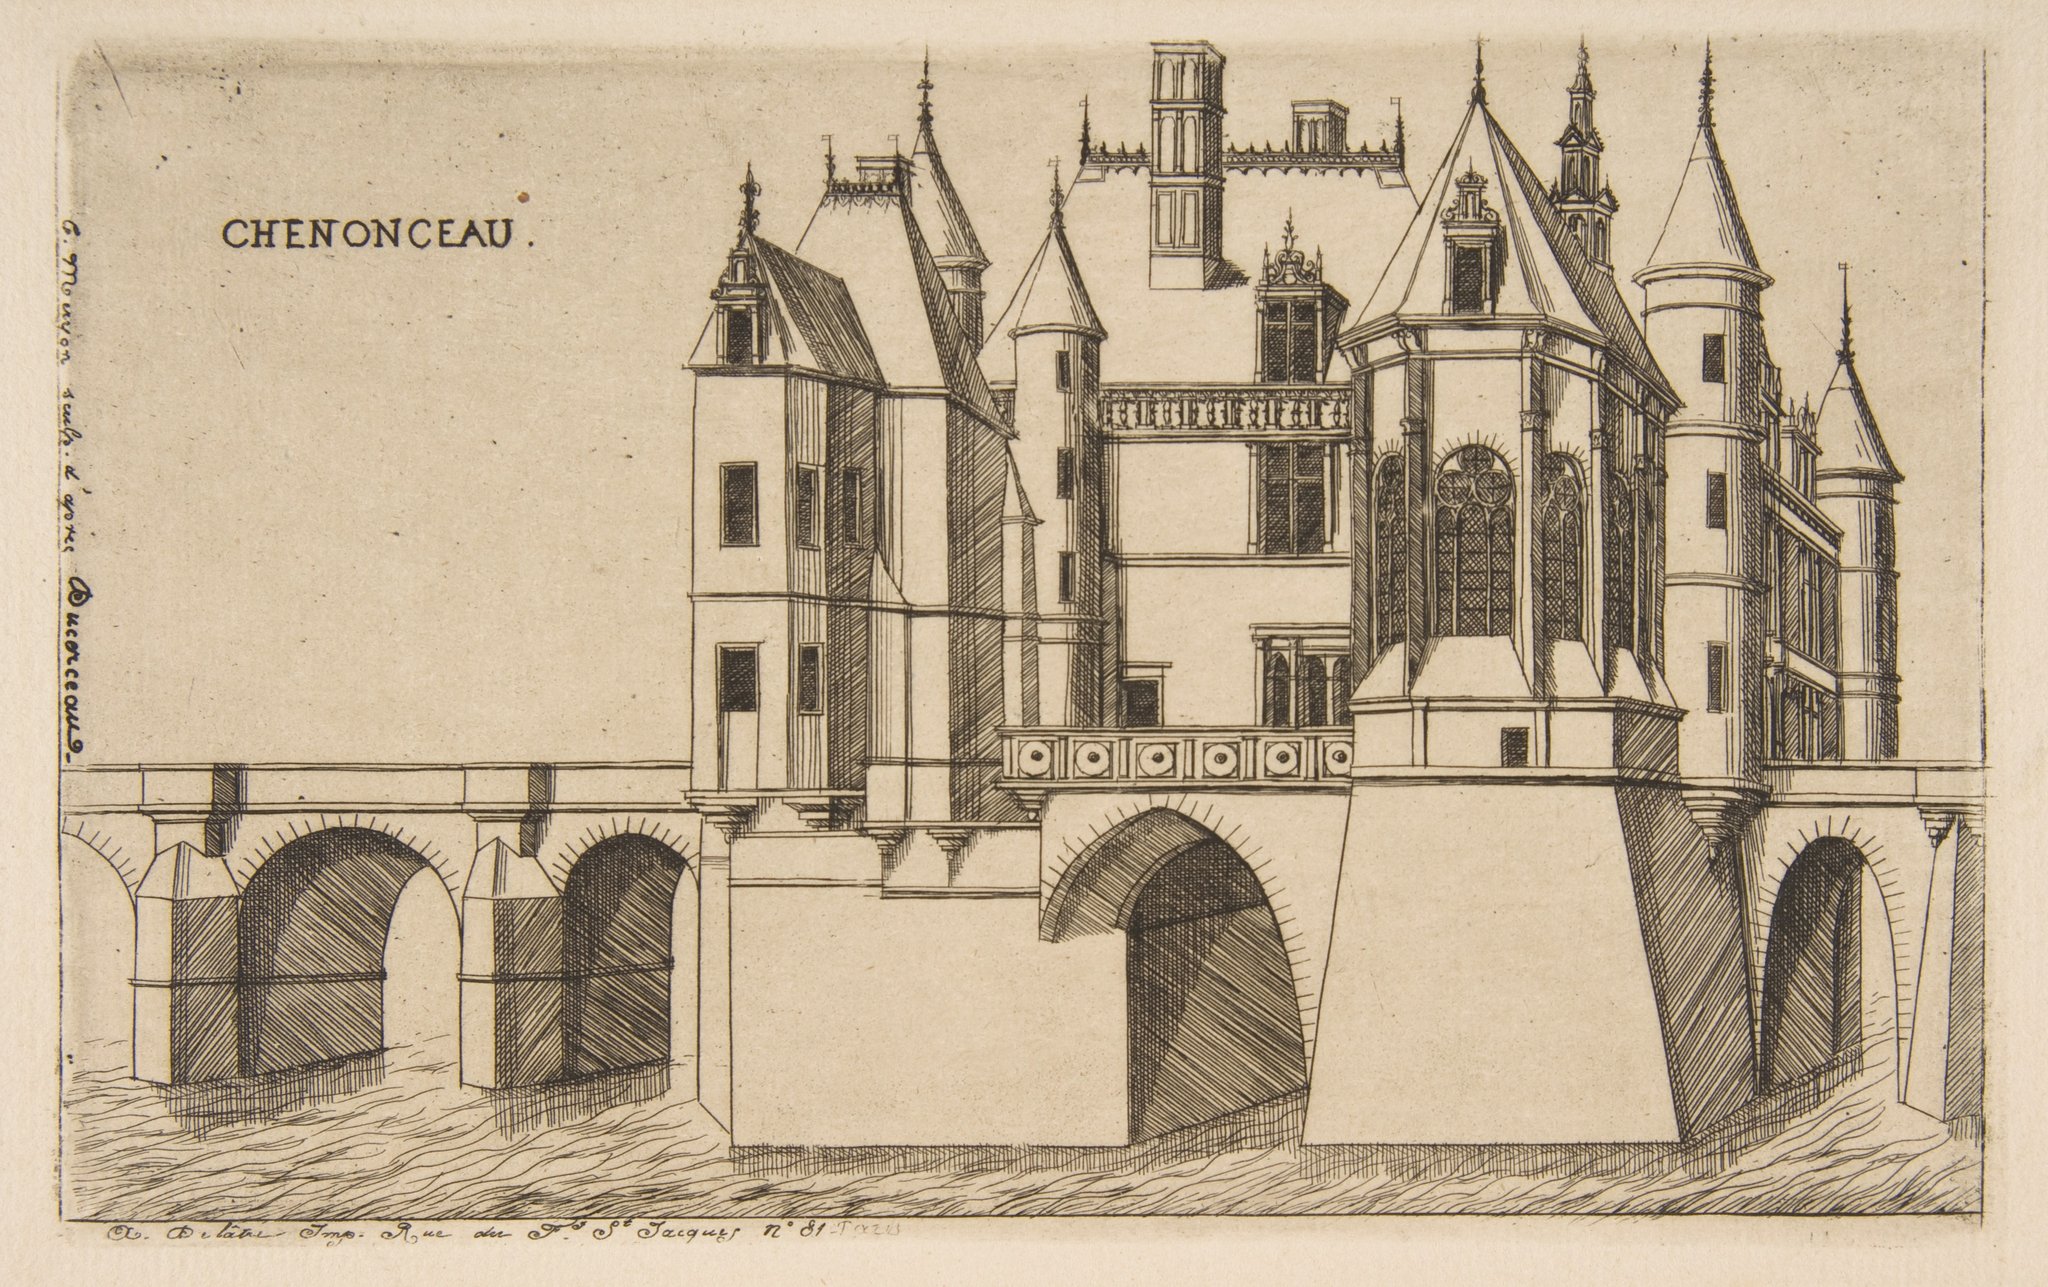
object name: print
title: Château de Chenonceau, No 2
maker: charles meryon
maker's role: artist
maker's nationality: french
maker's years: 1821-1868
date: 1856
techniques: etching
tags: buildings,castles,bridges